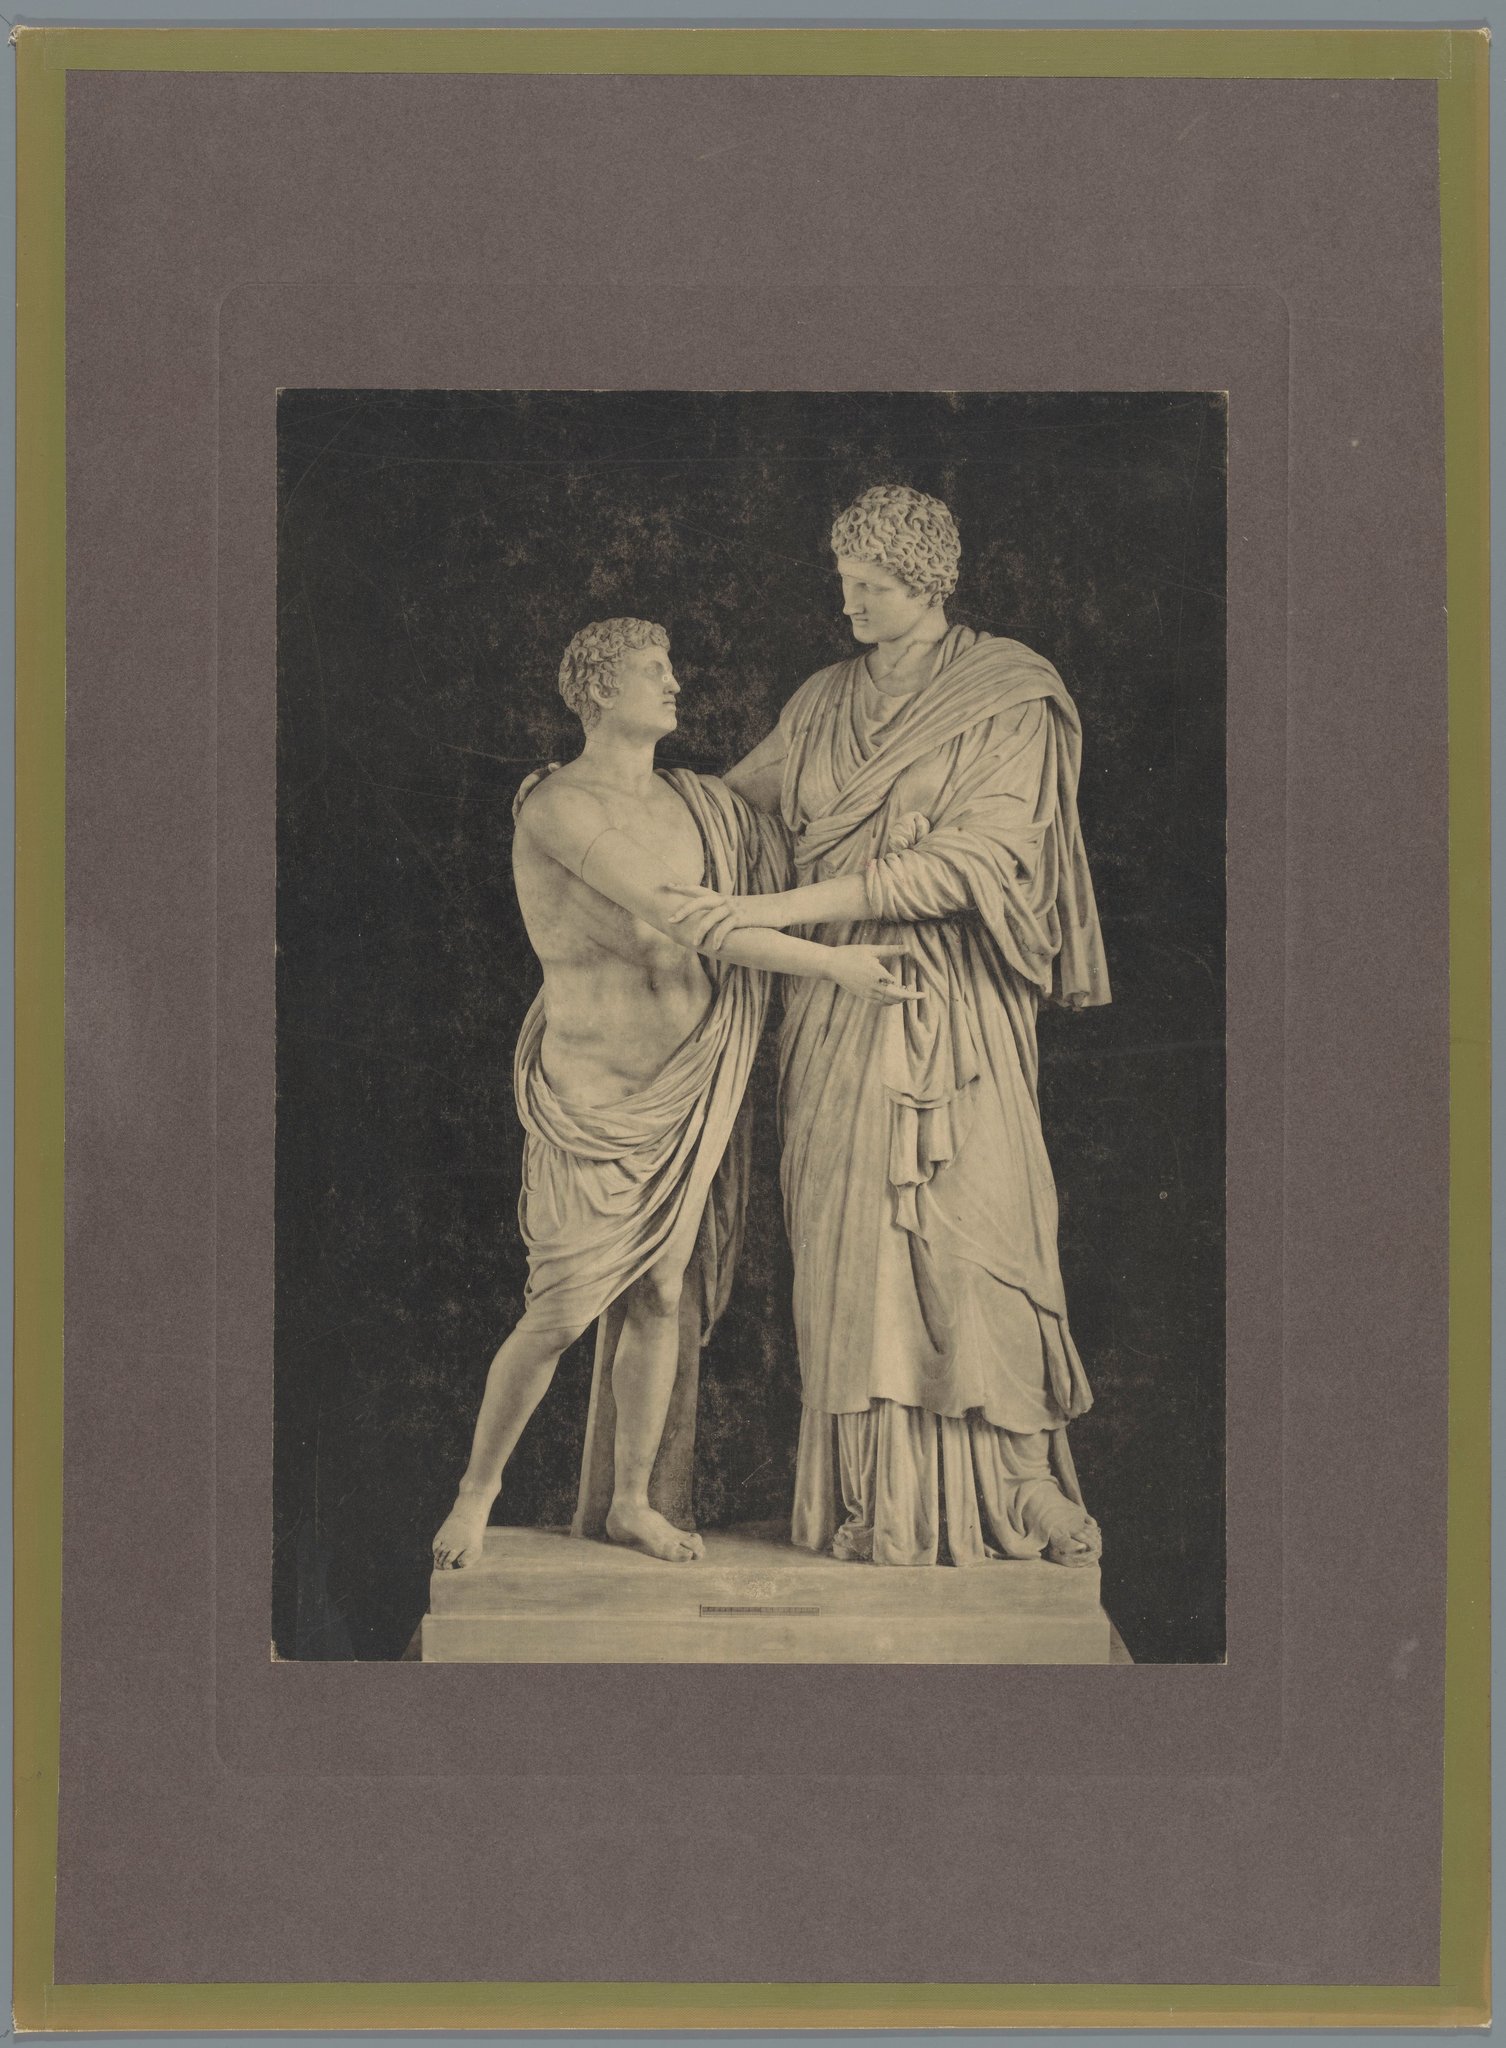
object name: photograph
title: Orestes und Elektra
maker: Anonymous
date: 1896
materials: cardboard, paper, ink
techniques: photograph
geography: europe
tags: 95a(orestes) (story of) orestes, 92e223 electra (pleiad), piece of sculpture, reproduction of a piece of sculpture, europe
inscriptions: number: ‘No. 26.’, inscription:, collector's mark: Lugt 3937